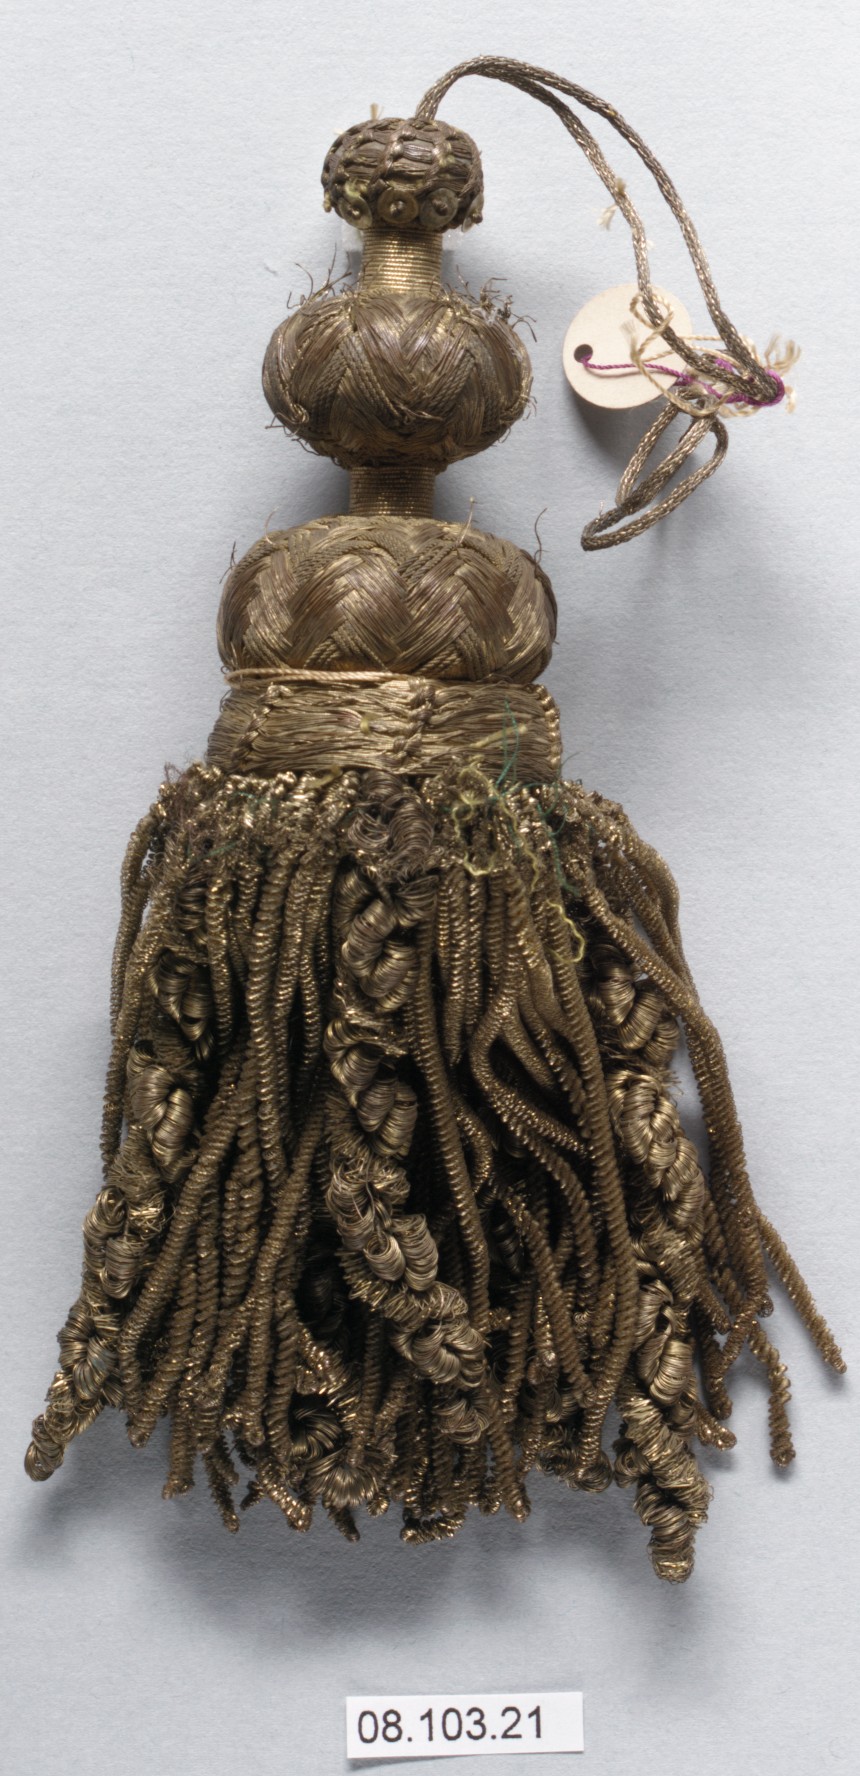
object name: tassel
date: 1801-1900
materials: metal thread